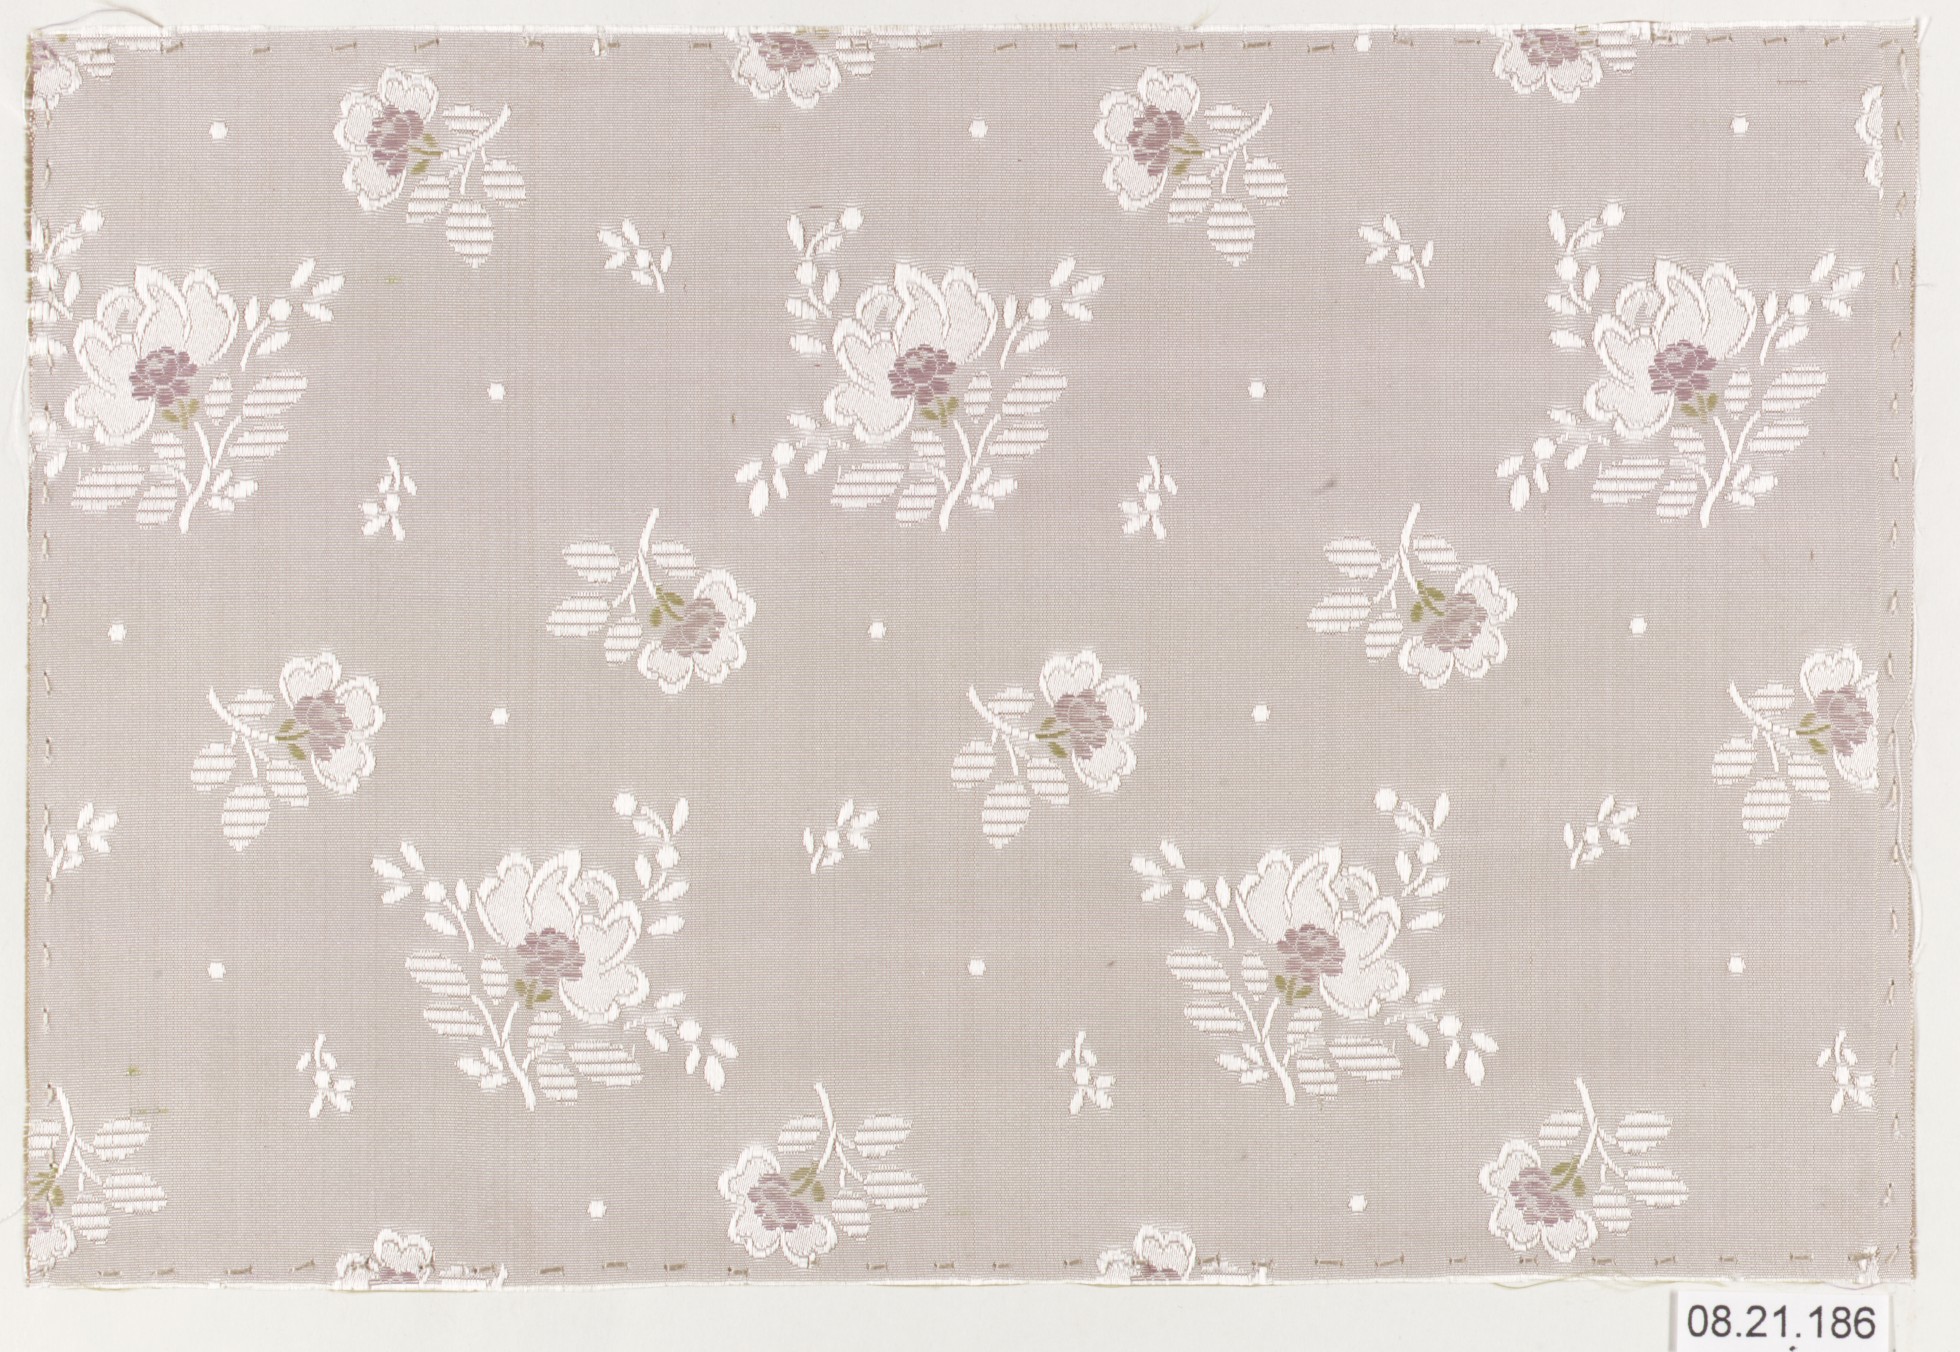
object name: textile sample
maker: Anonymous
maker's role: designer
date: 1900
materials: silk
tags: flowers